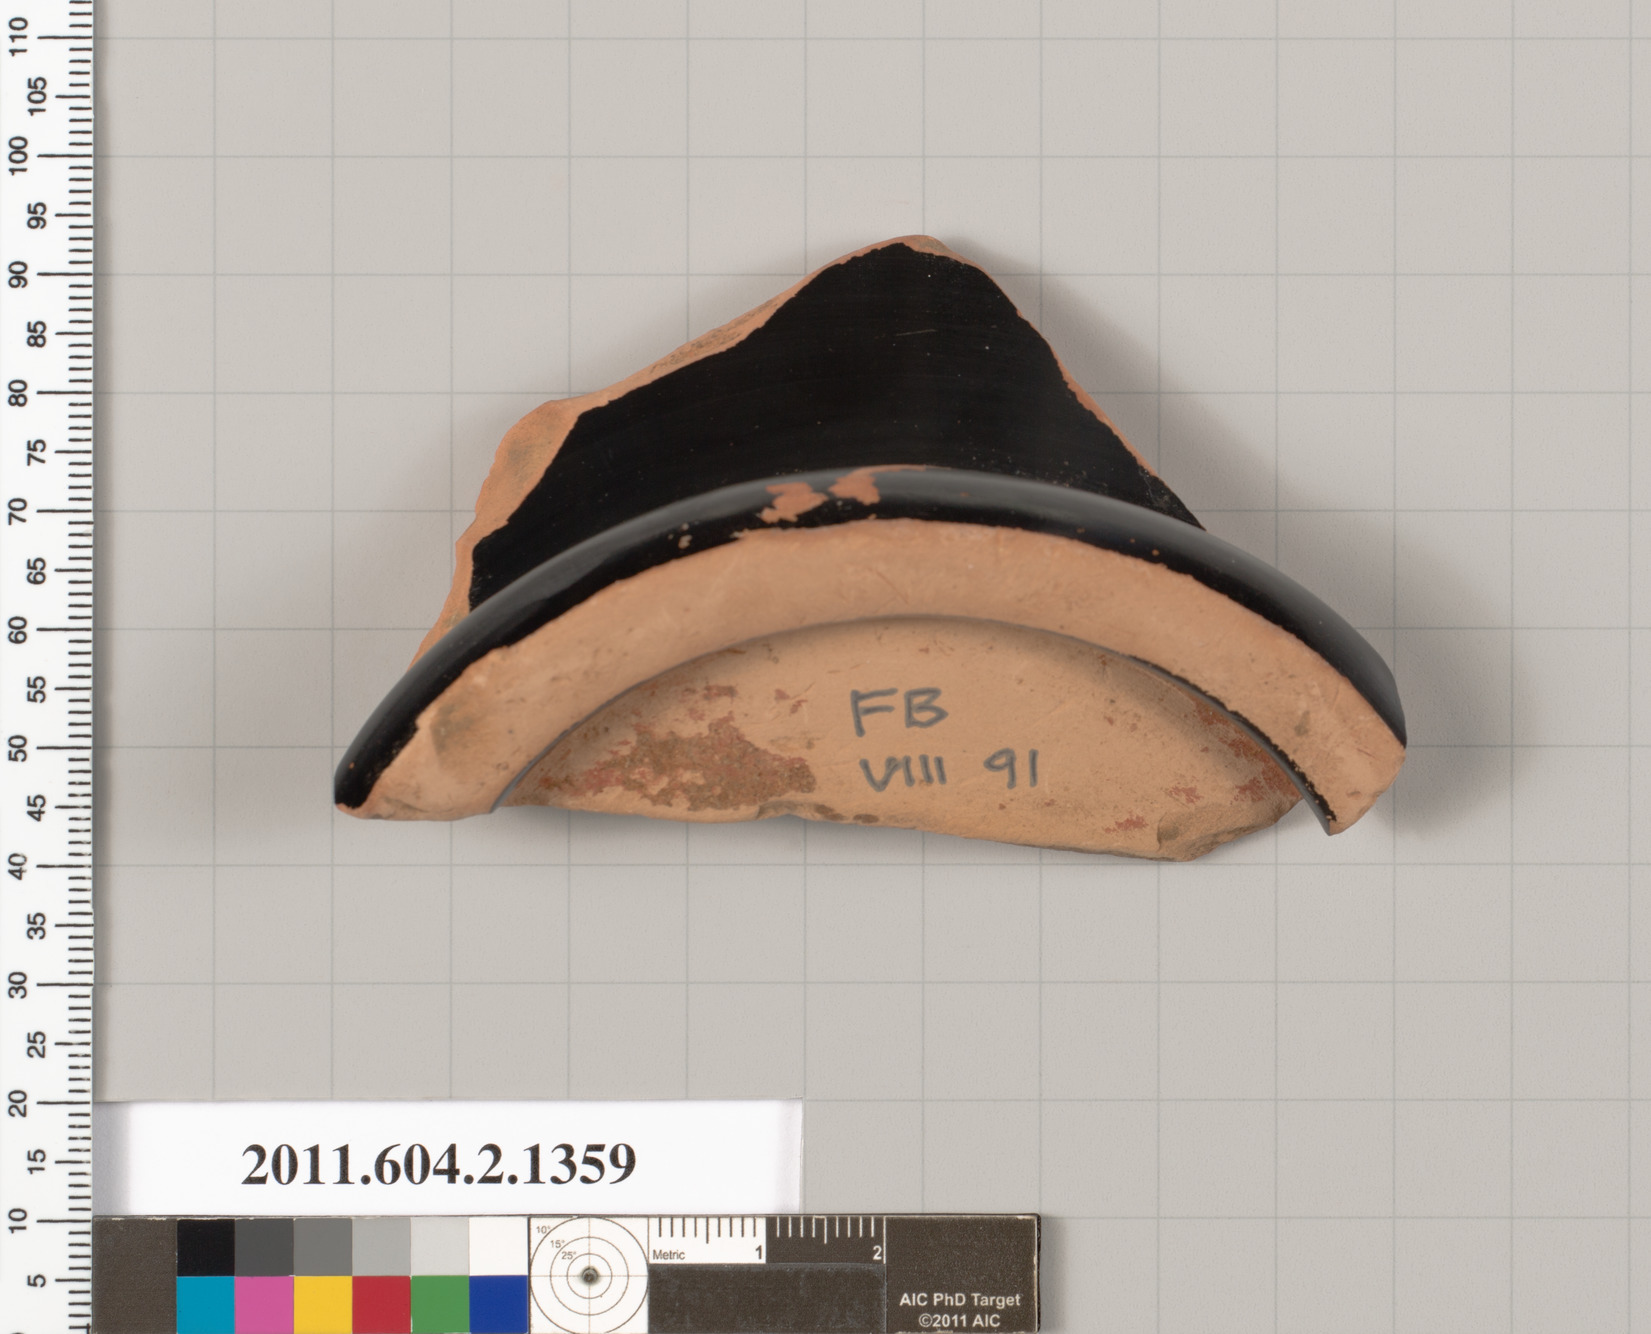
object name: skyphos fragment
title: Terracotta fragment of a skyphos (deep drinking cup)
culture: greek, attic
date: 475-451 BCE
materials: terracotta